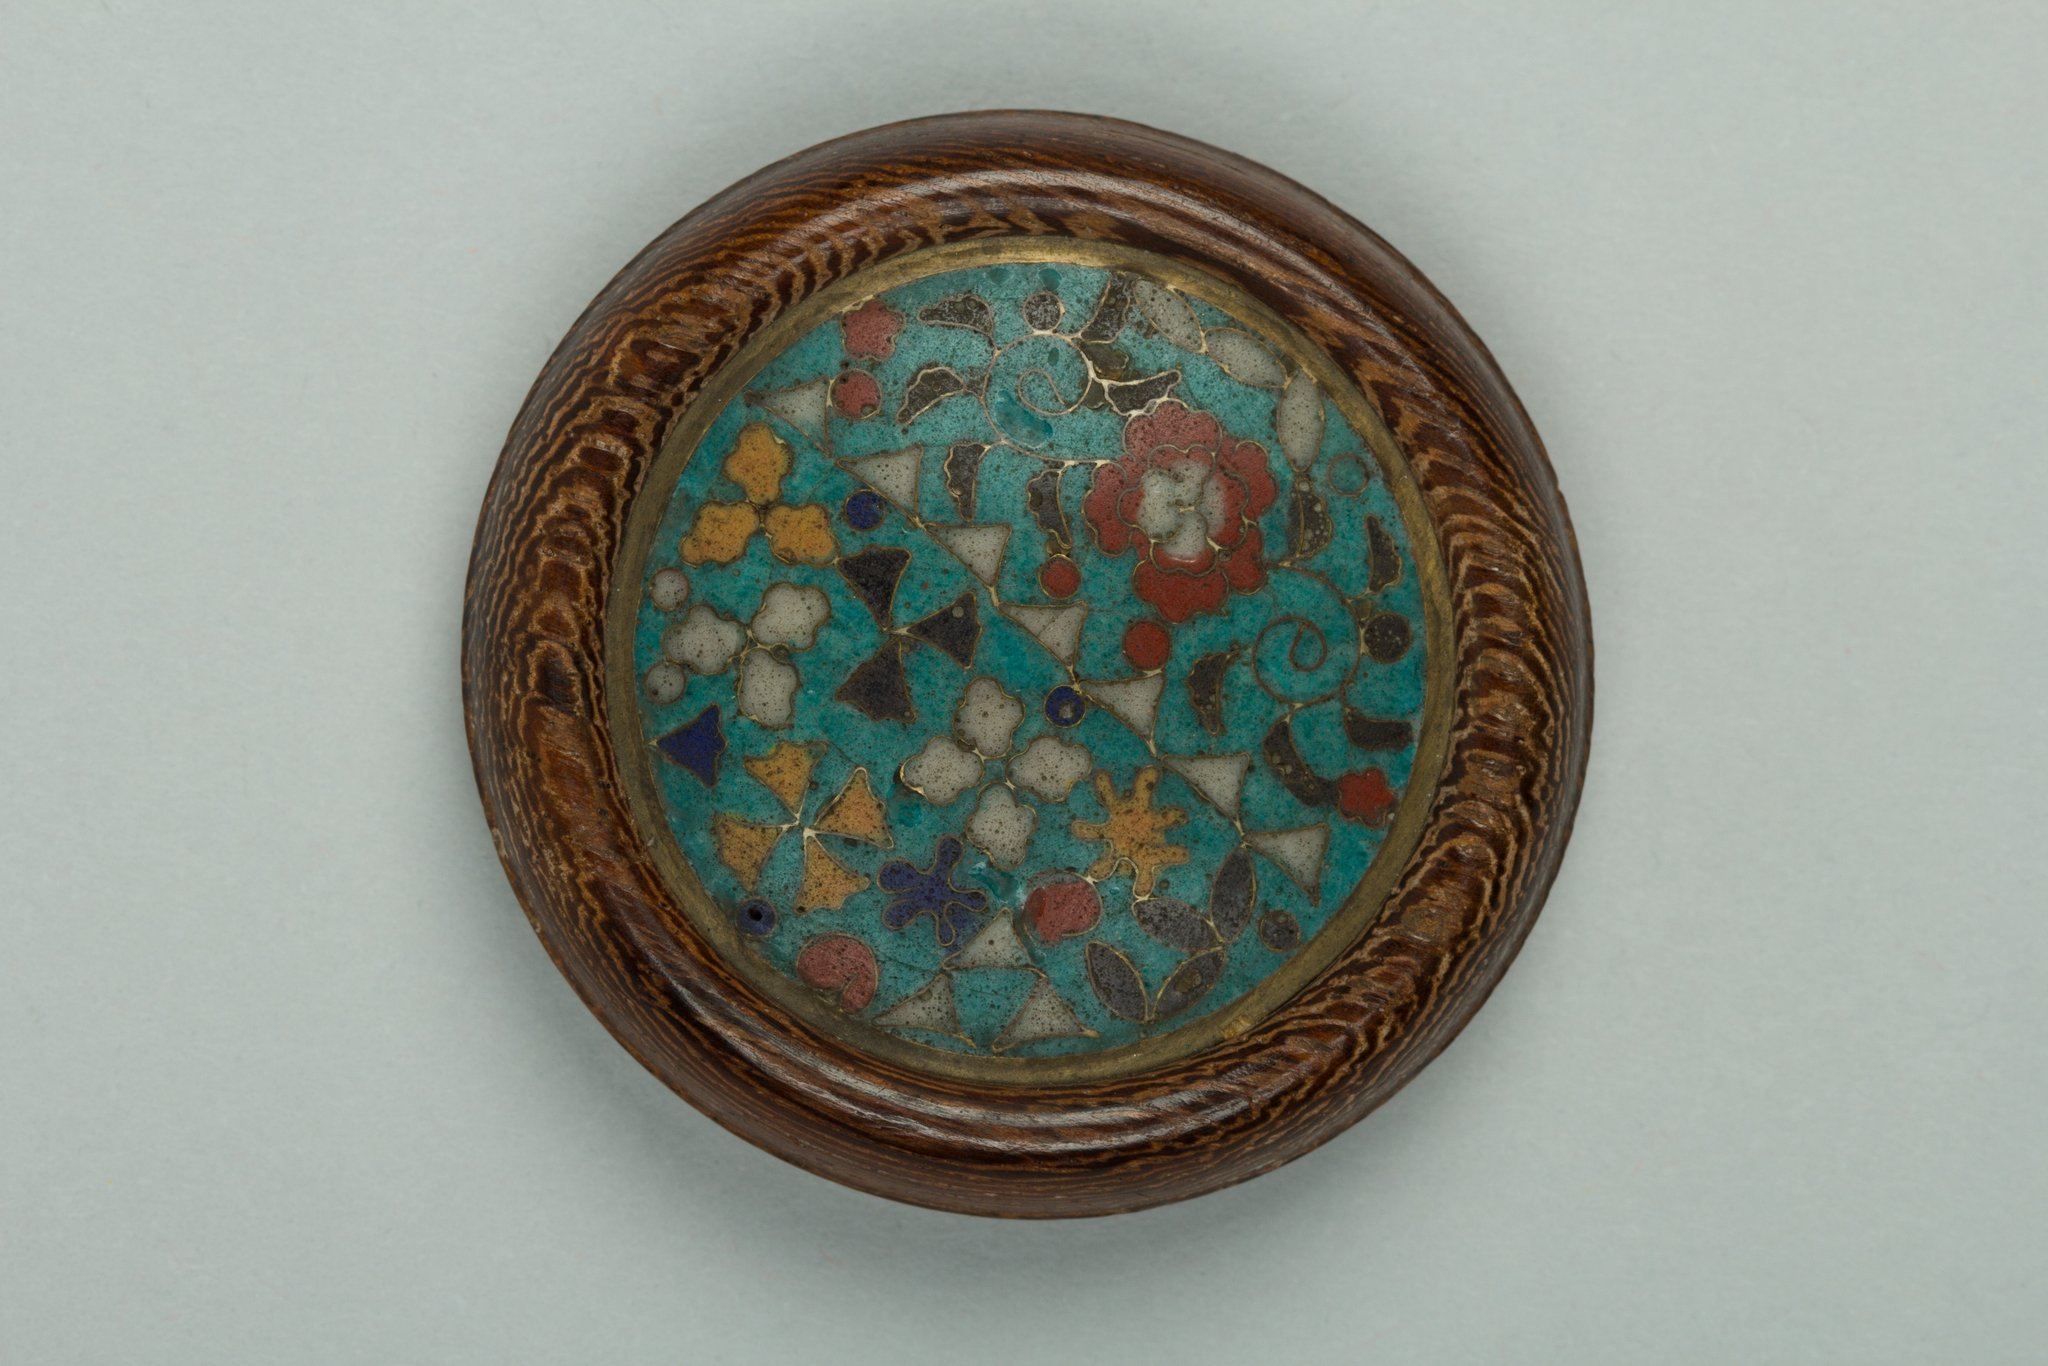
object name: netsuke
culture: japanese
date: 1801-1900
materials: enamel, wood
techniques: enamel